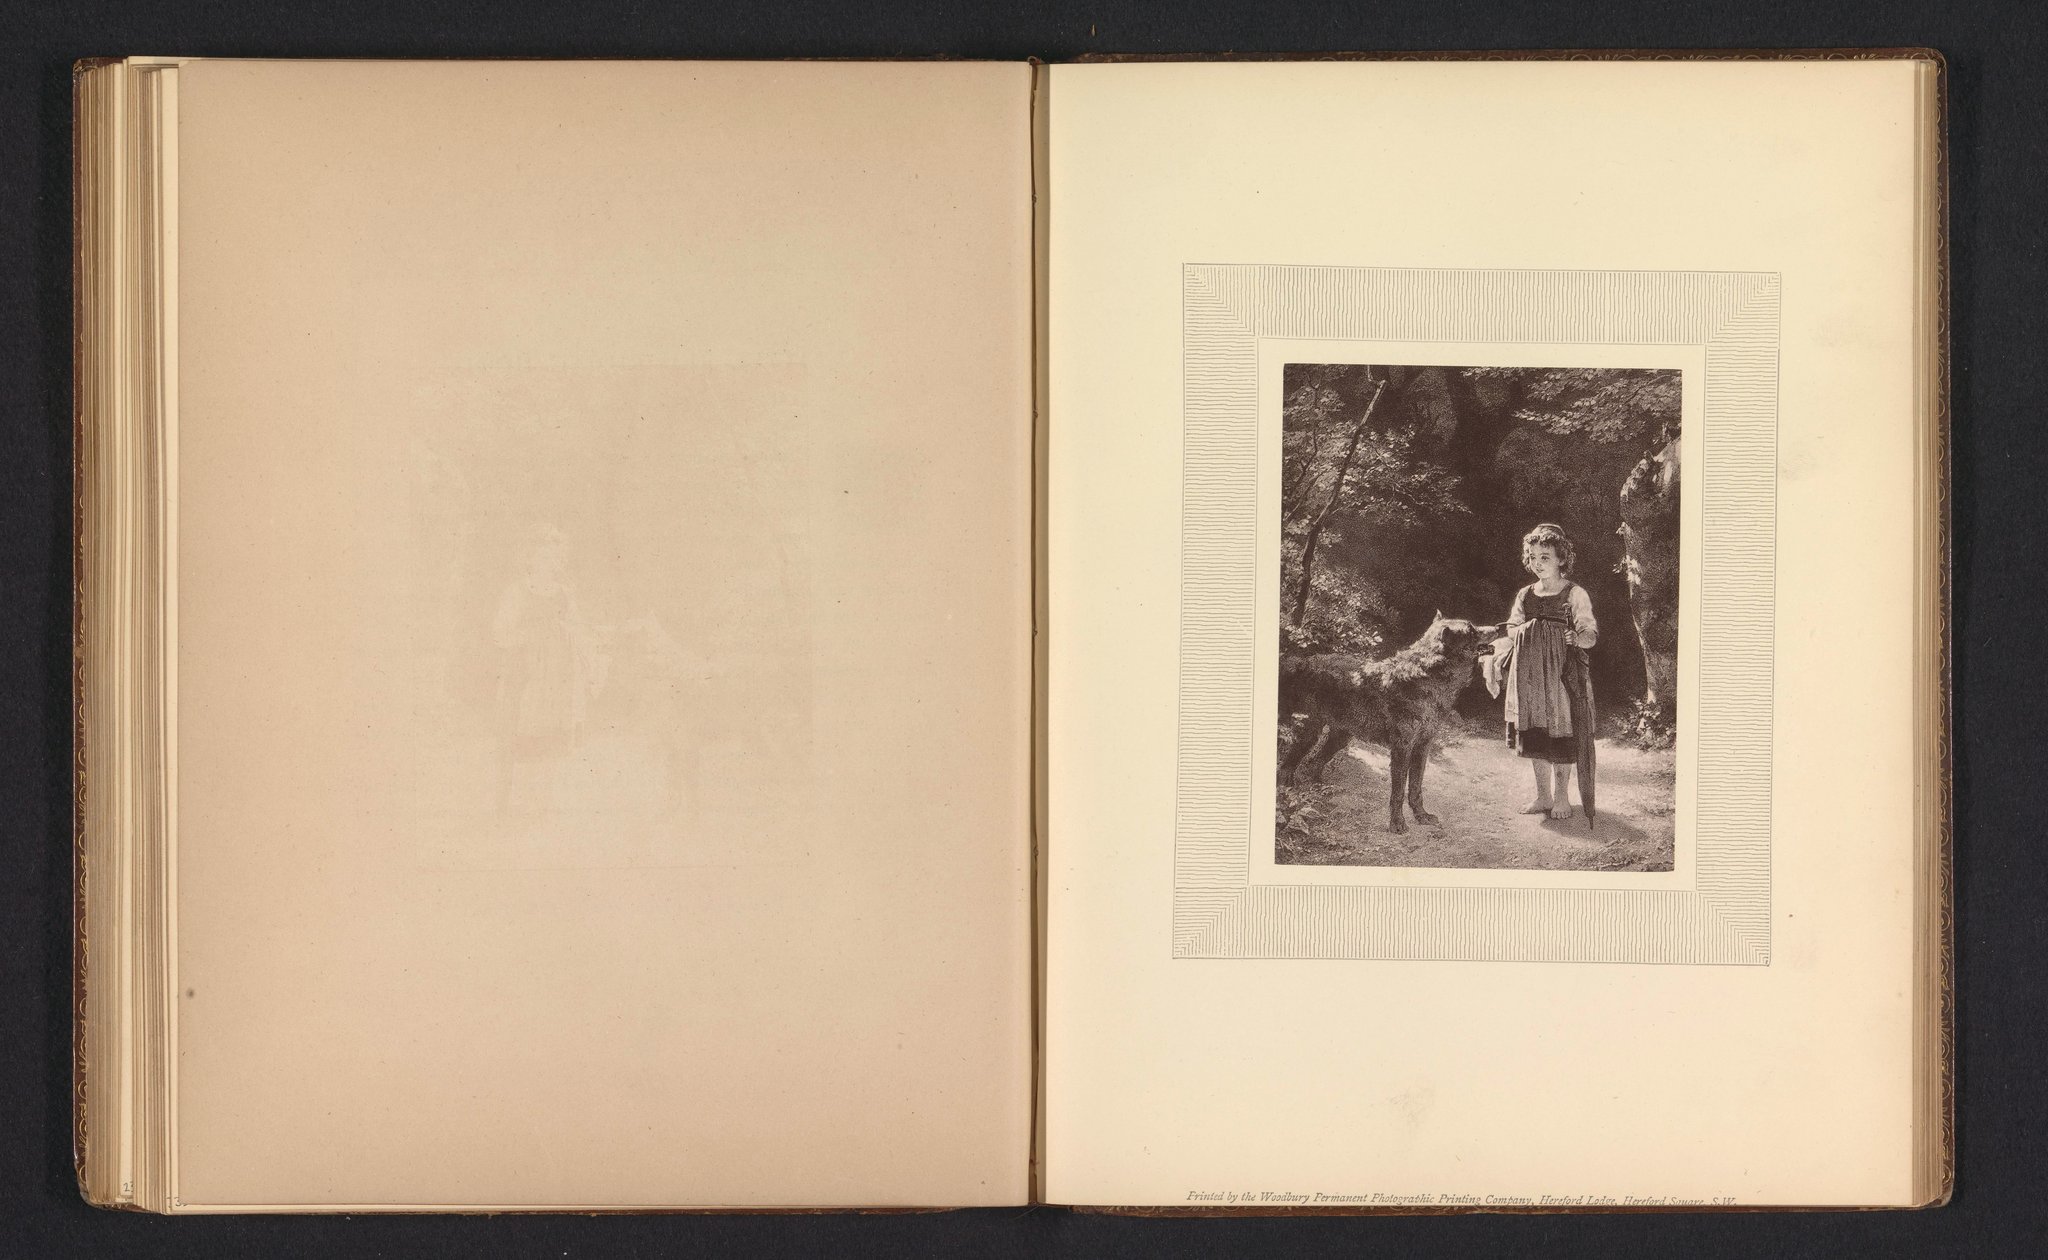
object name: page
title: Fotoreproductie van een prent naar een schilderij met een meisje en een wolf, mogelijk Roodkapje, door Ernst Bosch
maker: Anonymous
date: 1864-1874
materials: paper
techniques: woodburytype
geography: london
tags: tales and fairy tales: little red riding-hood, picture, painting